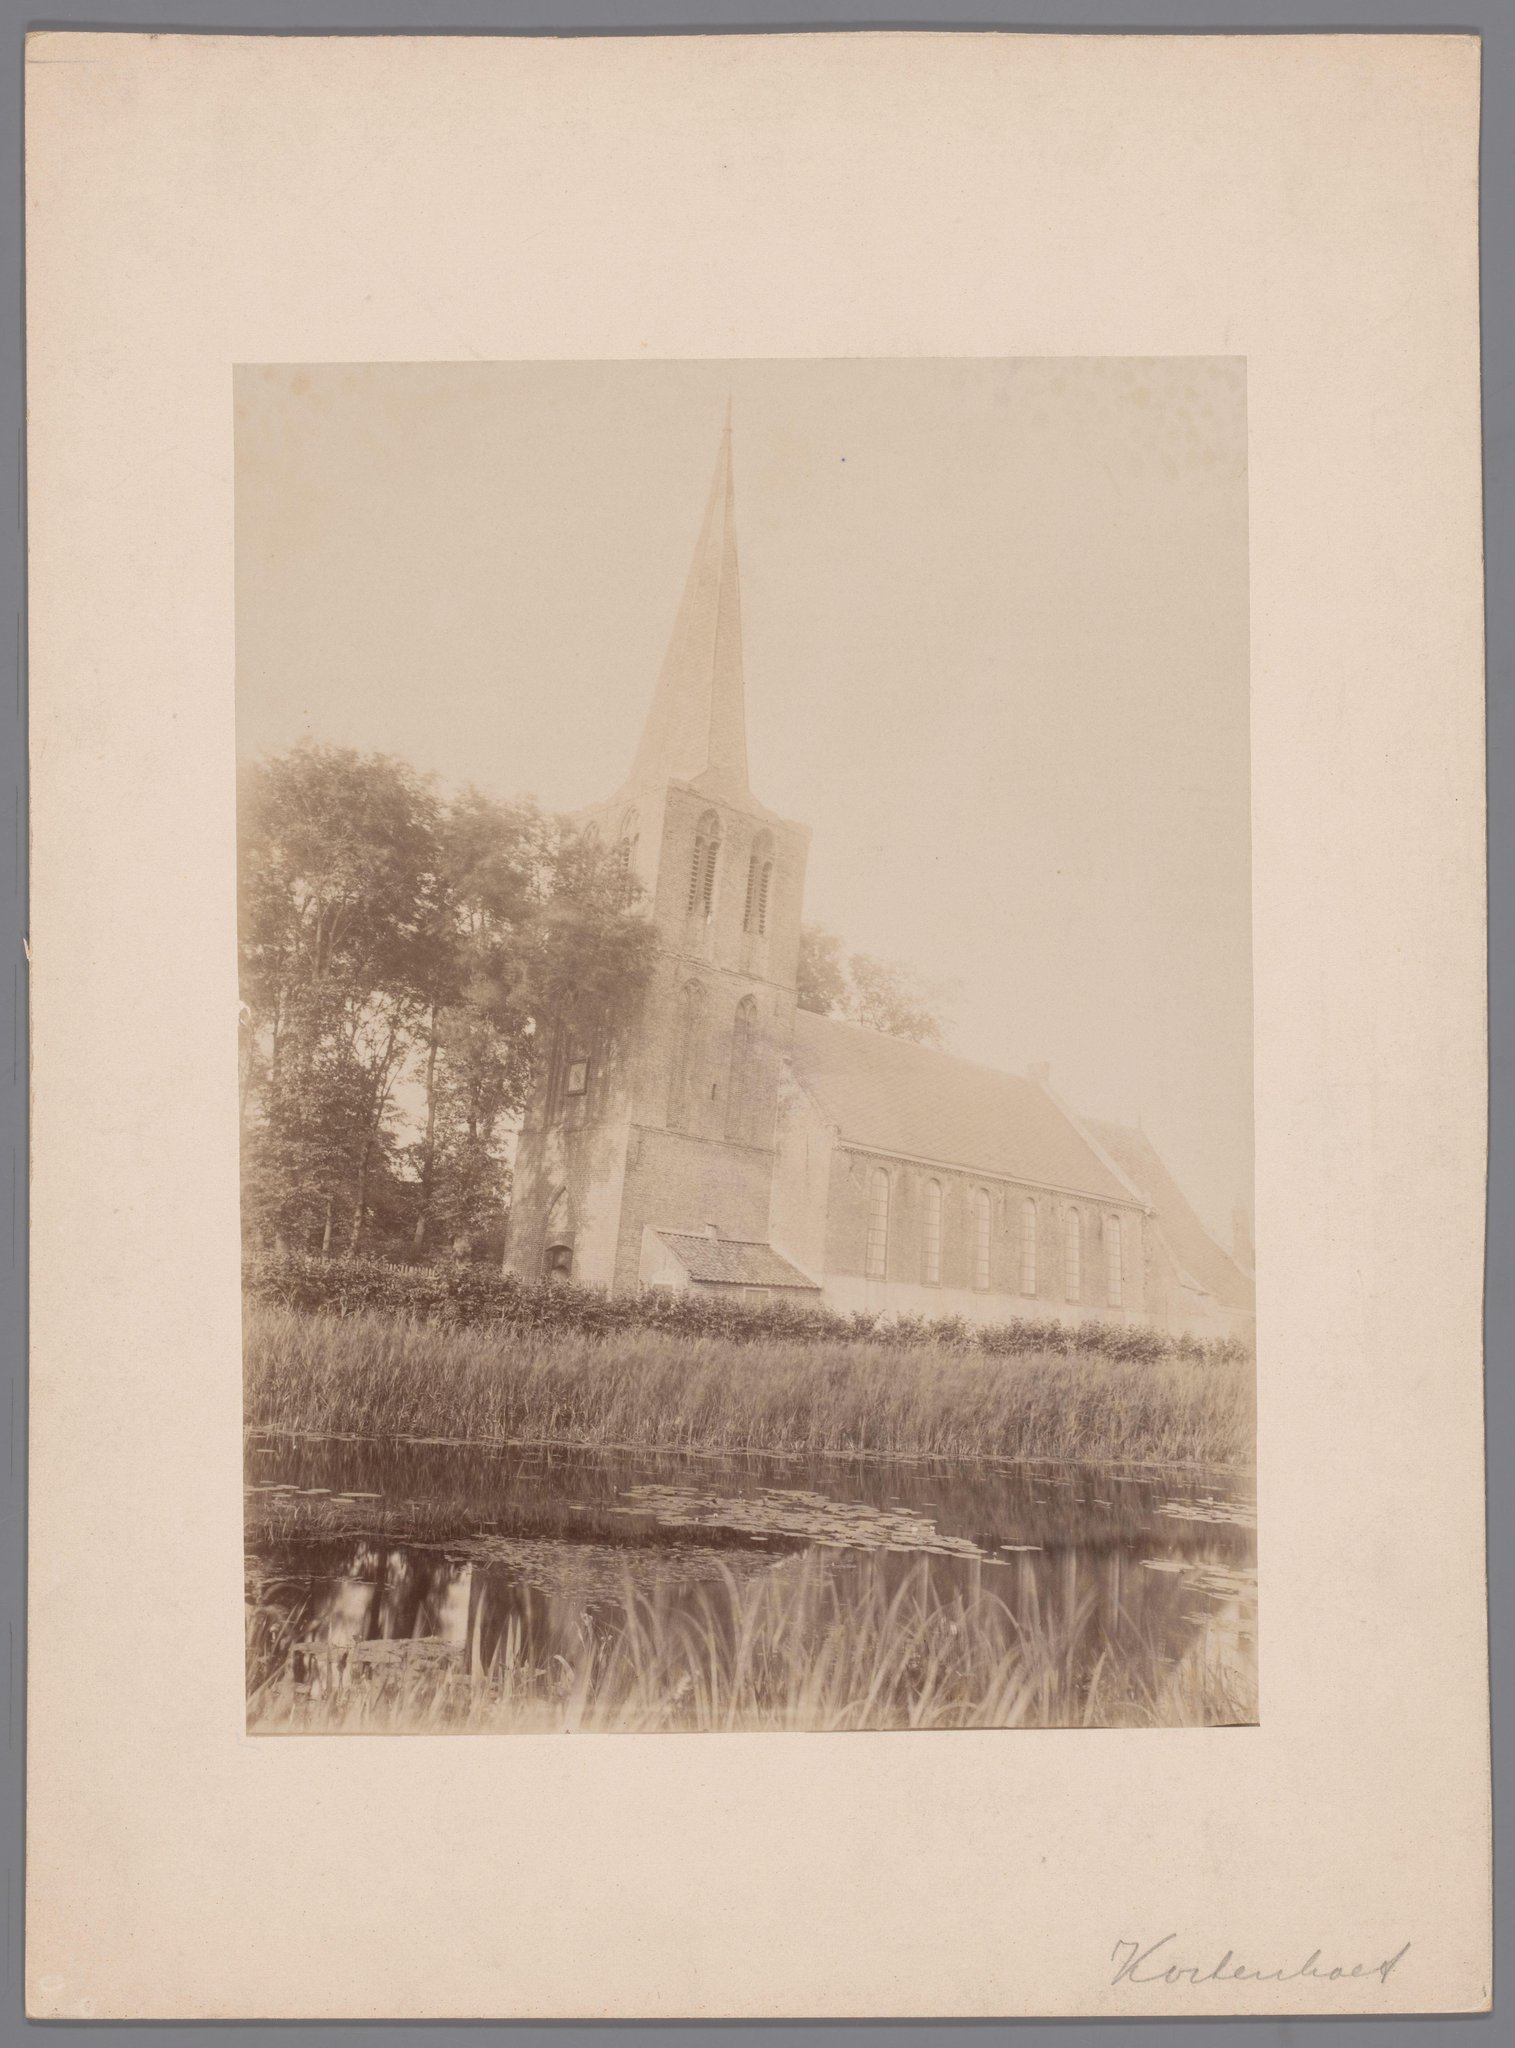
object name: photograph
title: Gezicht op de Hervormde Kerk van Kortenhoef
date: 1904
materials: cardboard, photographic support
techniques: albumen print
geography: kortenhoef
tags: church (exterior)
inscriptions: annotation: ‘Kortenhoef’, annotation: ‘Kerk der Ned. Herv. gemeente te Kortehoef/ Juli 1904’